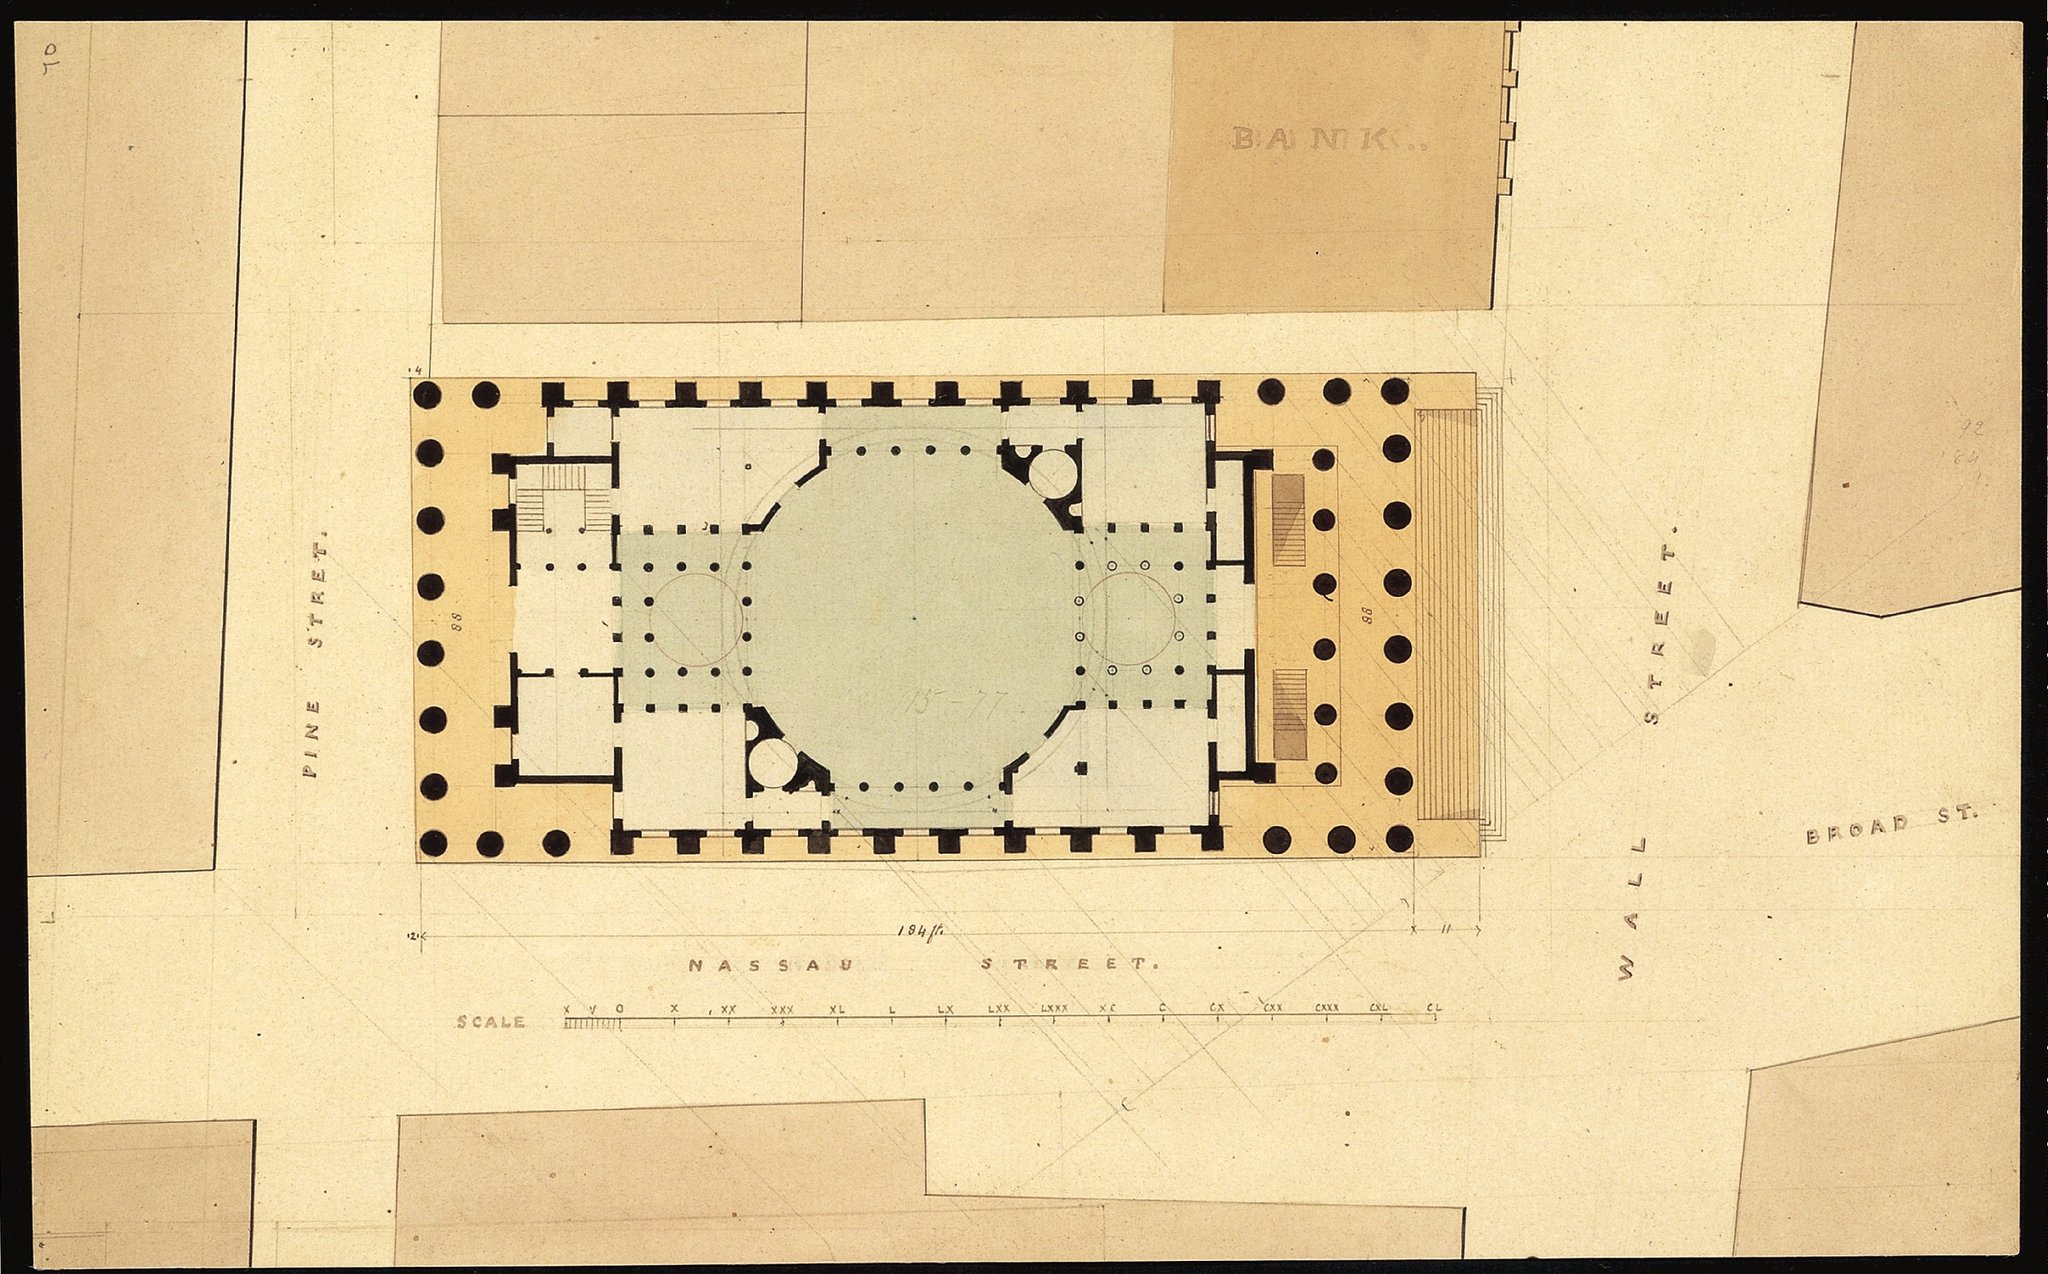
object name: drawing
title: Plan of U. S. Custom House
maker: ithiel town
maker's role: artist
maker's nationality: american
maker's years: 1784-1844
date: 1801-1833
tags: architecture